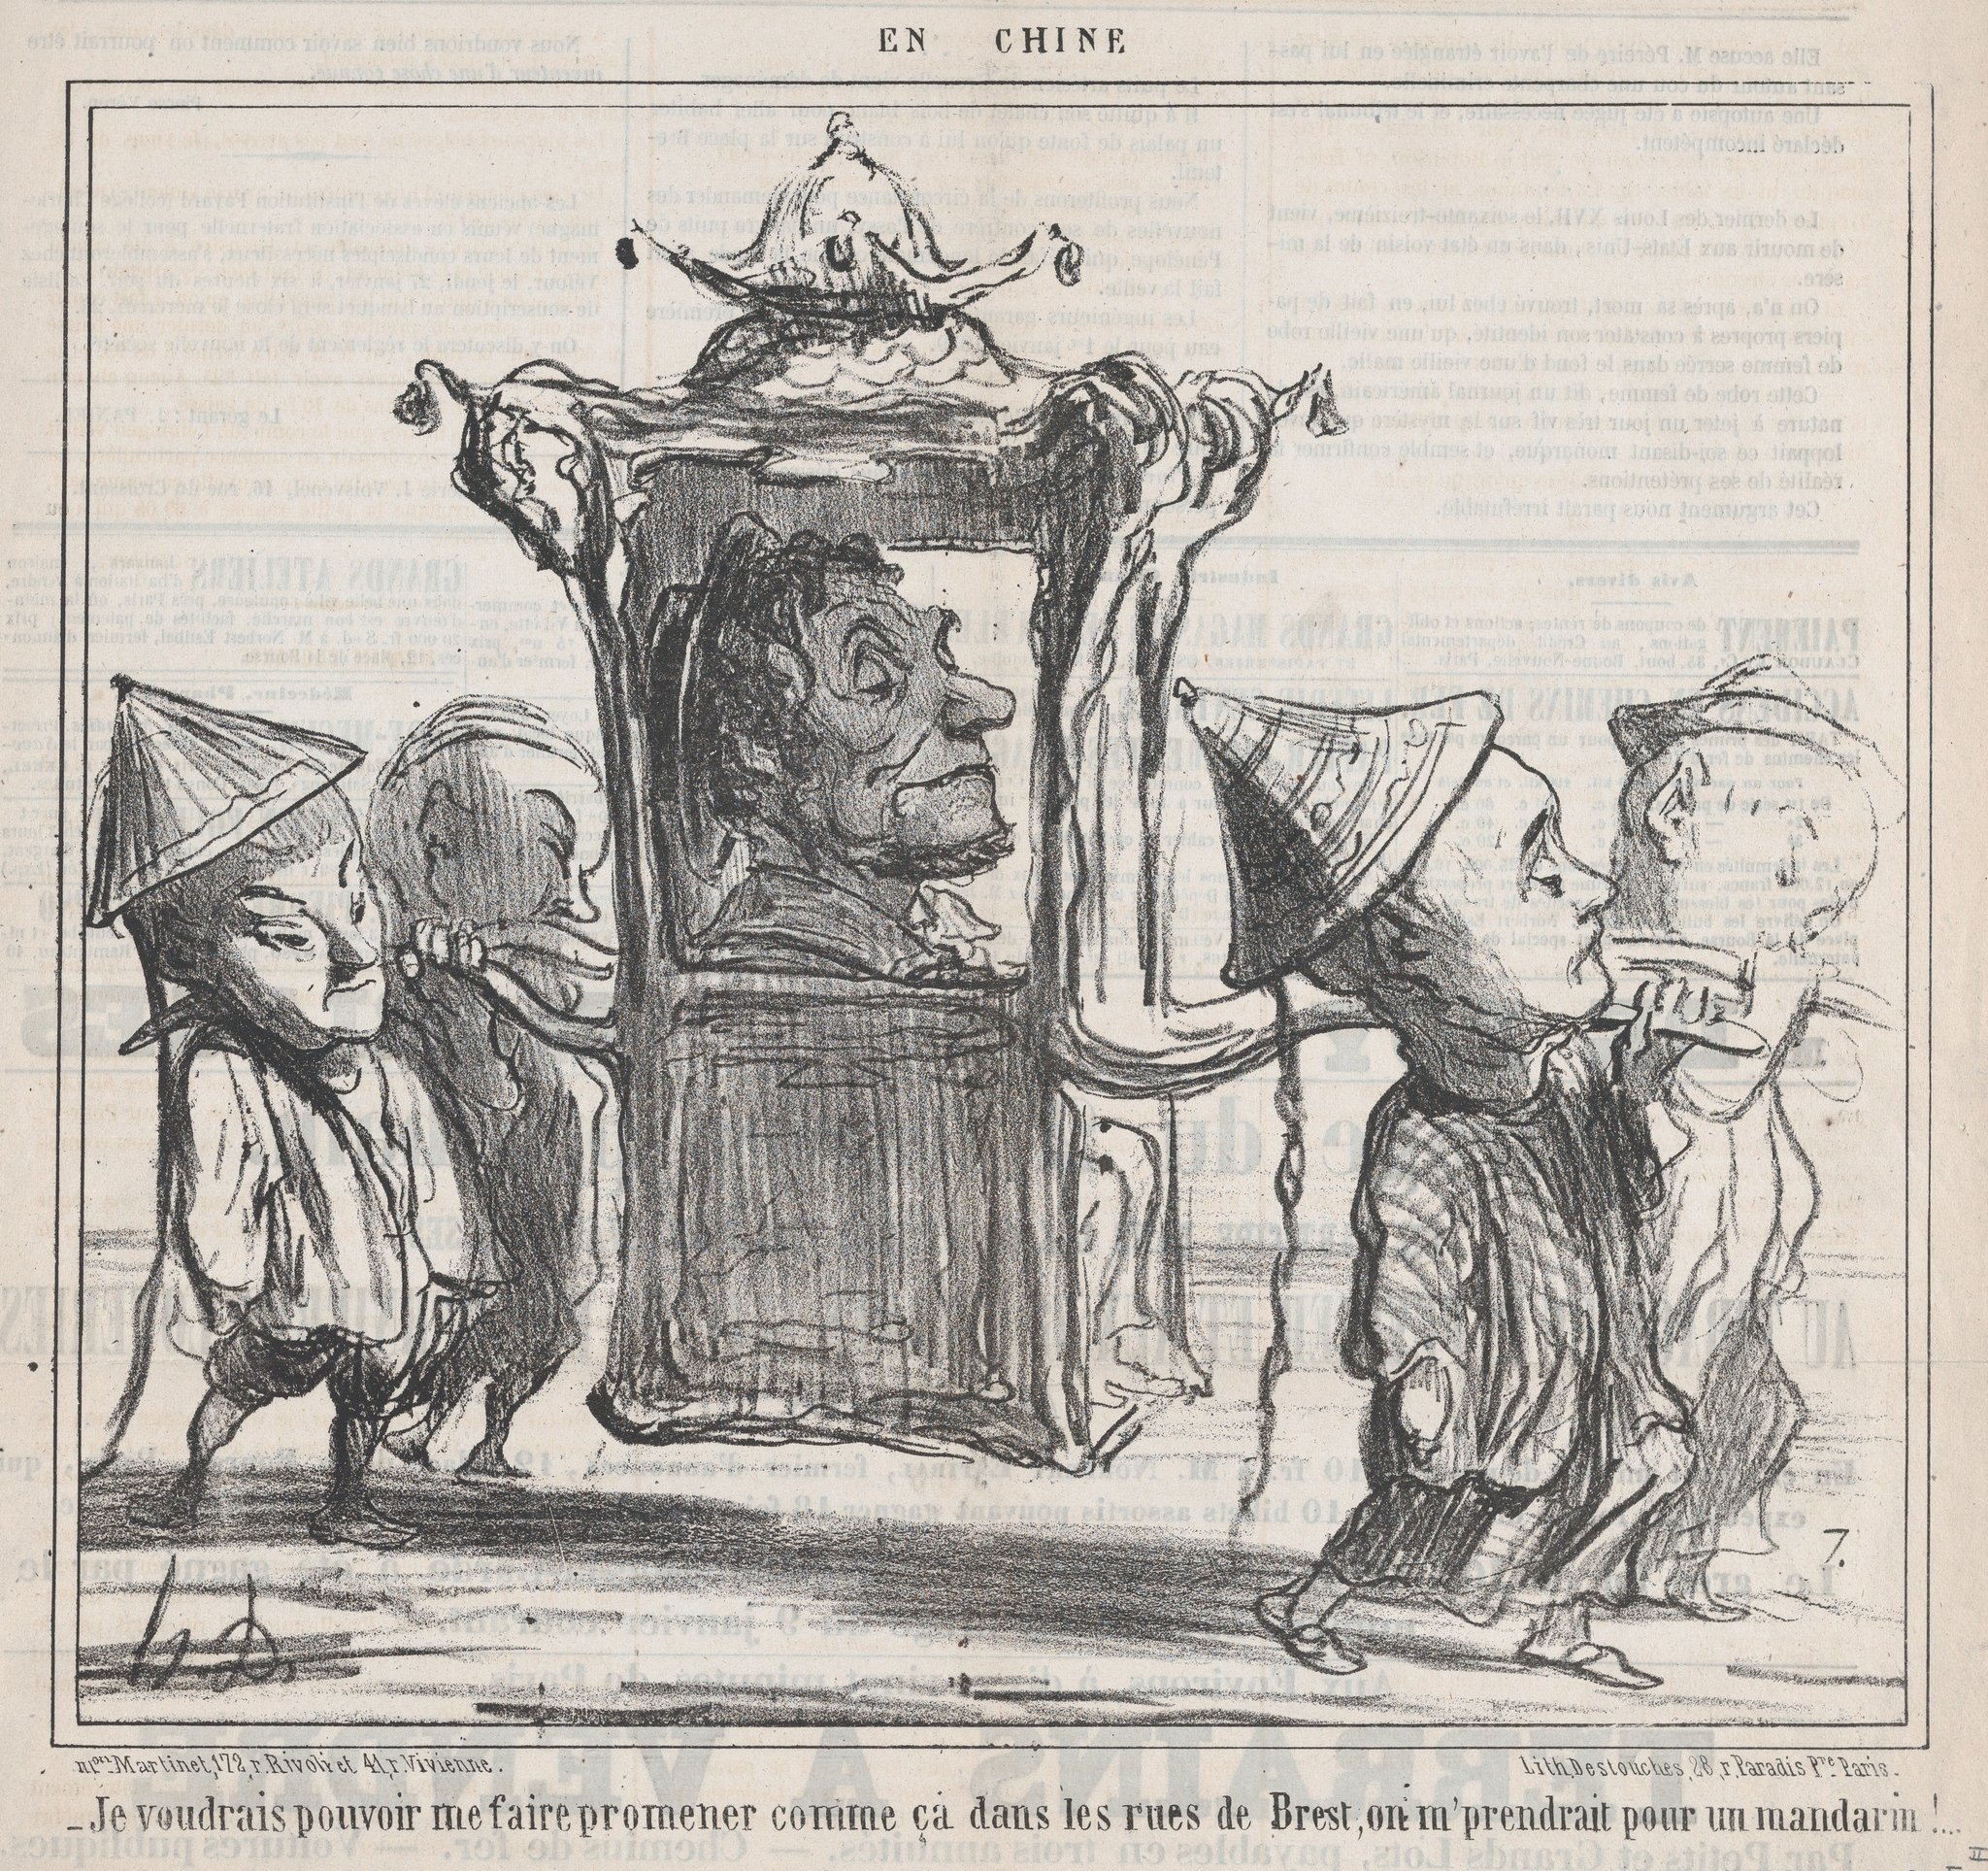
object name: print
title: Je voudrais pouvoir me faire promener, from "En Chine"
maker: honoré daumier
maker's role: artist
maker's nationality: french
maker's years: 1808-1879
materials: paper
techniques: lithograph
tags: satire,men